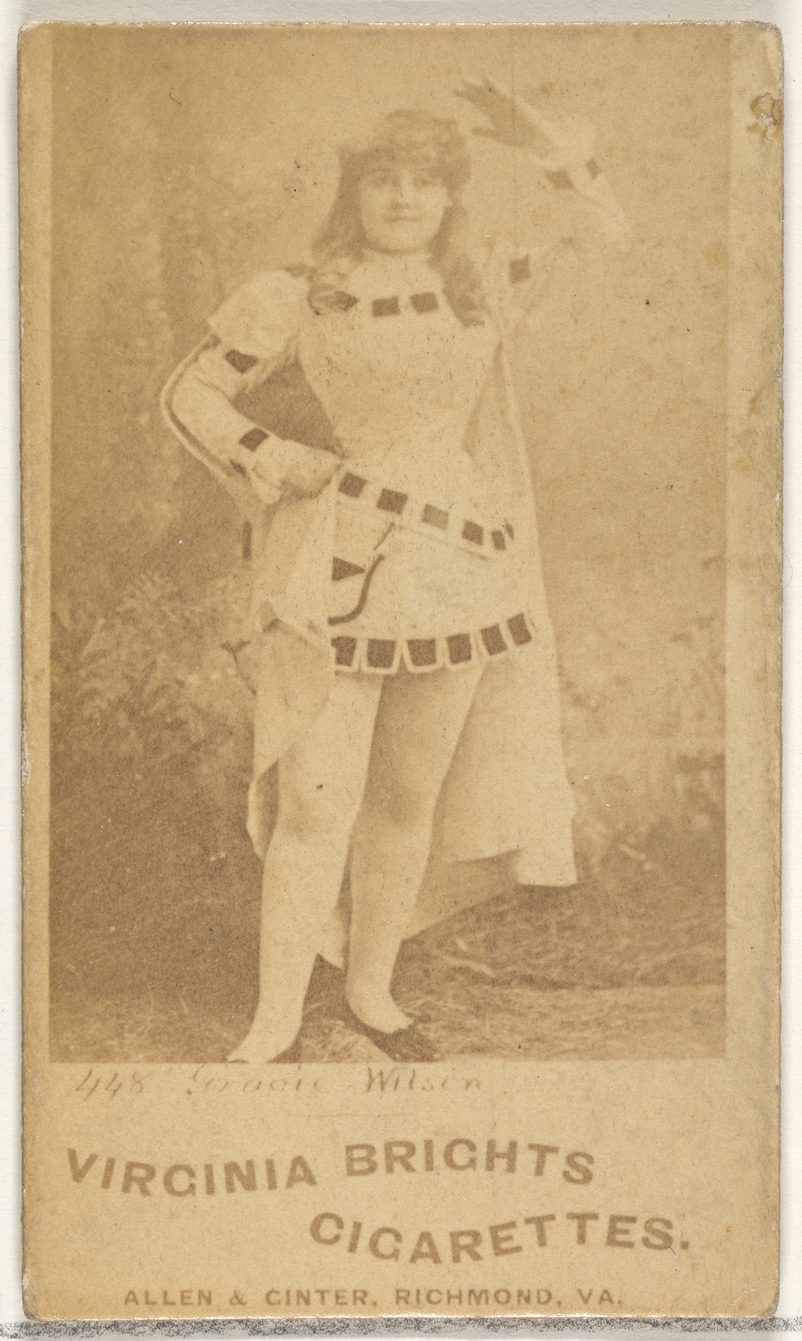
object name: photograph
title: Card 448, Gracie Wilson, from the Actors and Actresses series (N45, Type 1) for Virginia Brights Cigarettes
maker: allen & ginter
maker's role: publisher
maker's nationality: american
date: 1888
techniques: albumen silver print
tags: portraits,women,actresses